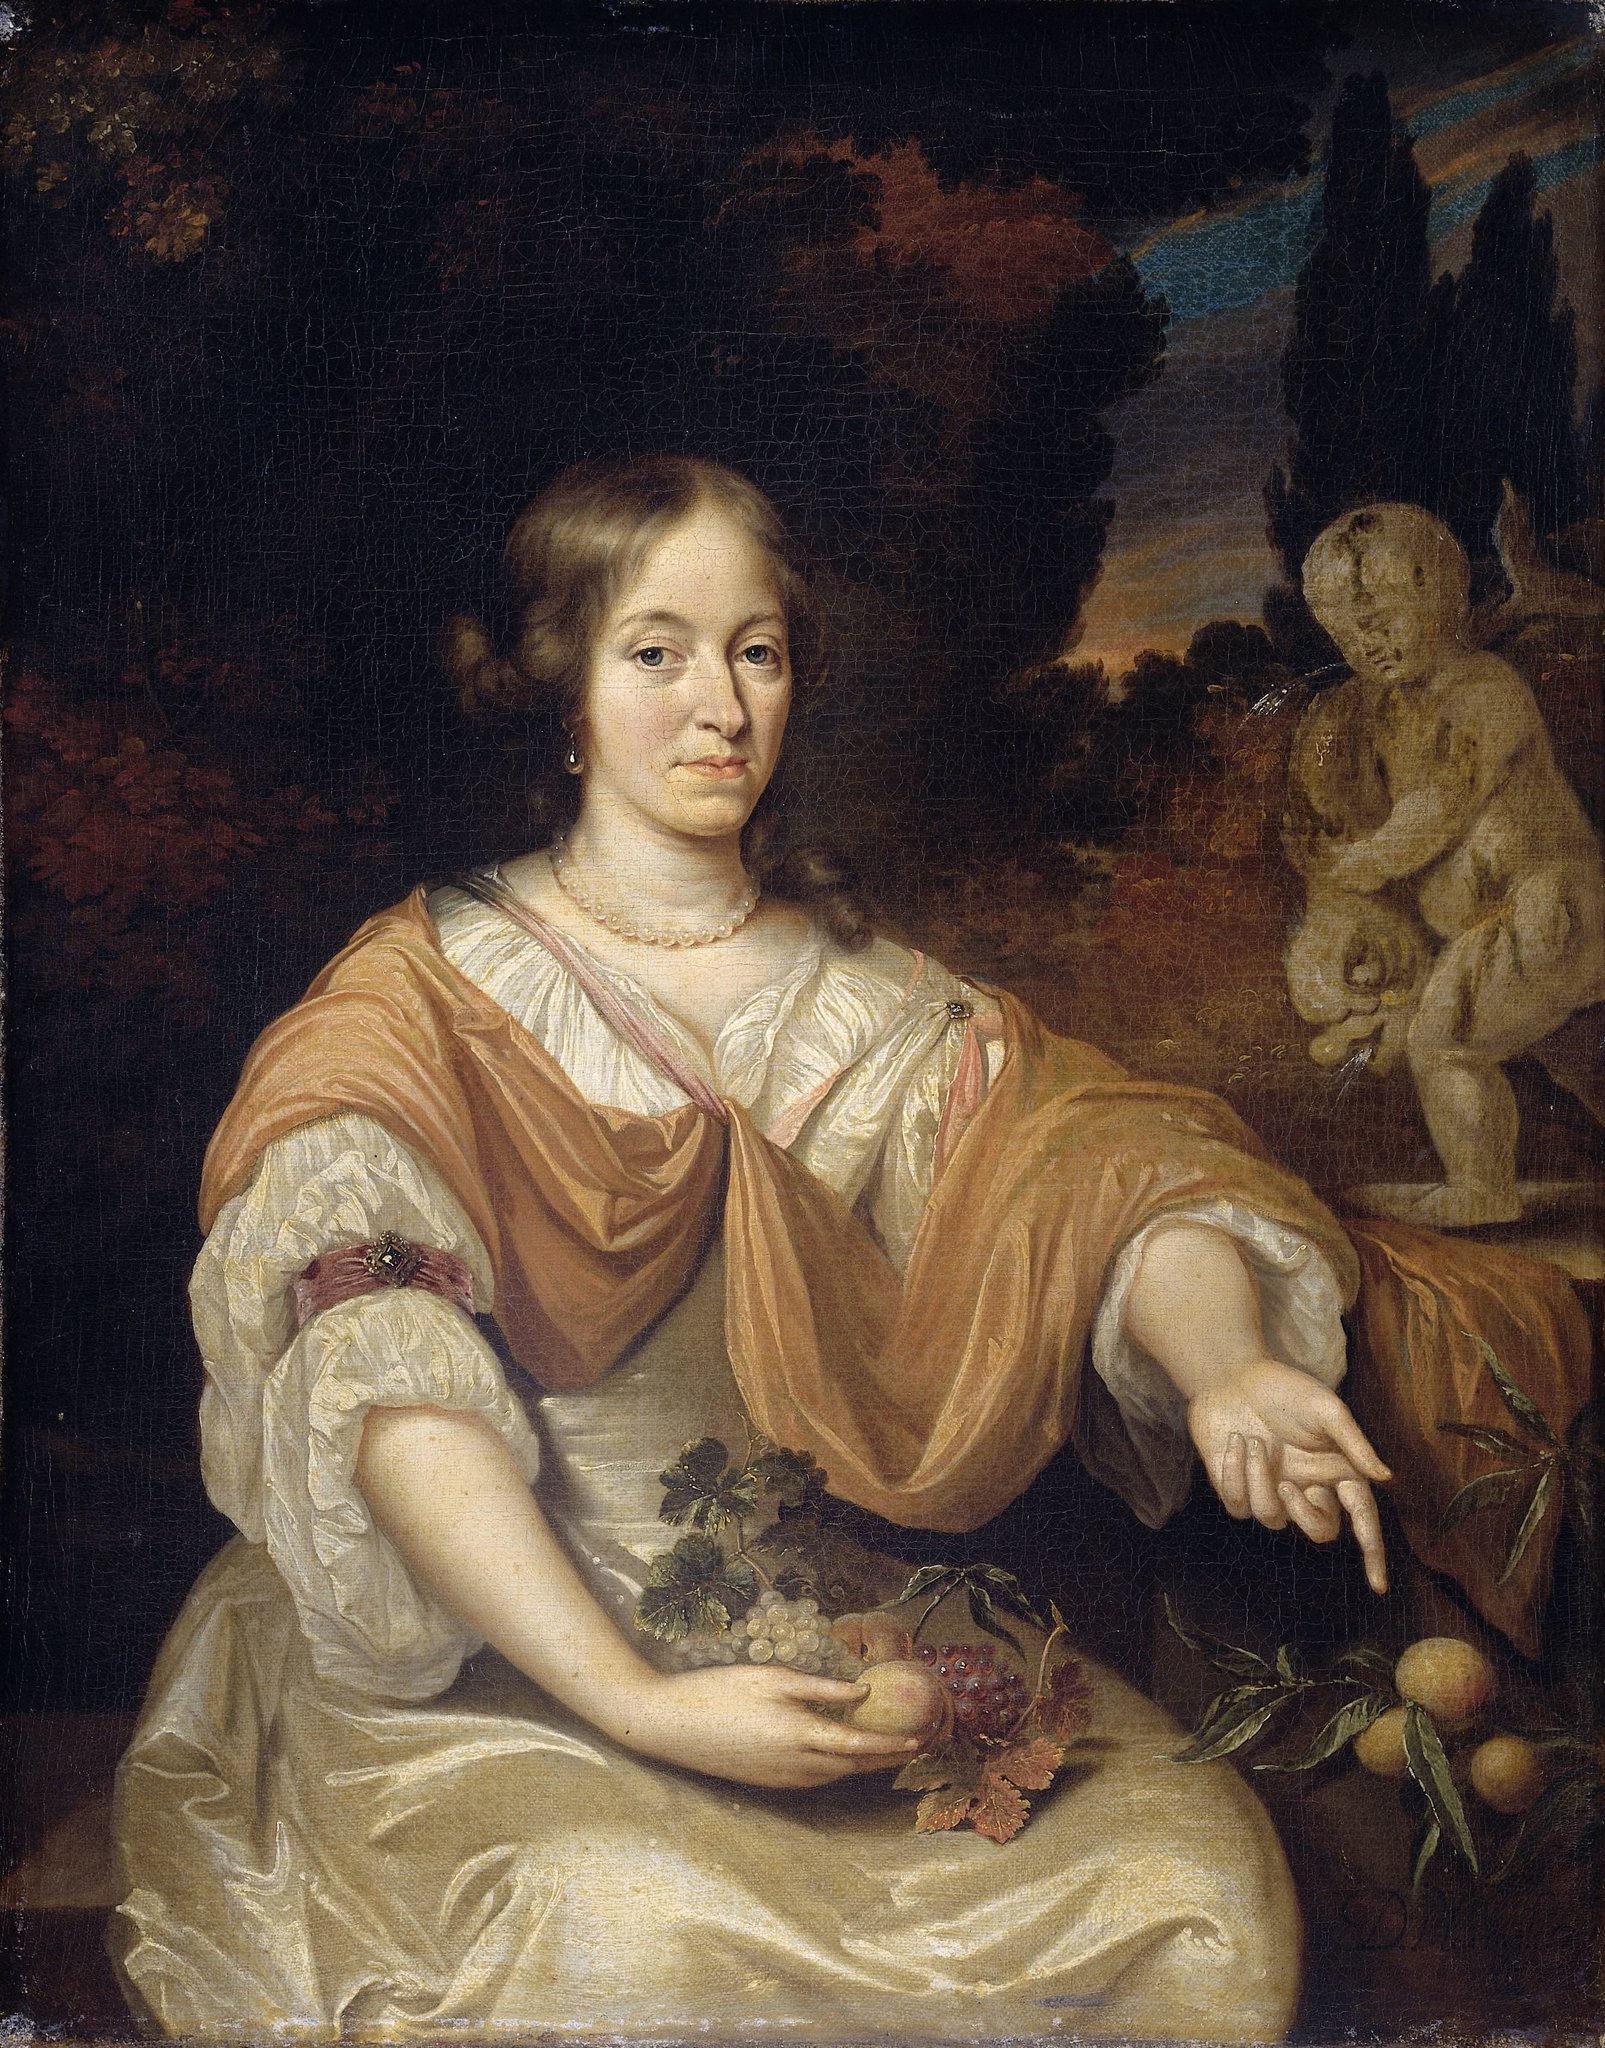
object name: painting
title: Sara Pottey (1651-1705), Wife of Johan van Bochoven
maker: daniël haringh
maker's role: painter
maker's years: 1636-1713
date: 1670-1690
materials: canvas, oil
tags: historical persons - bb - woman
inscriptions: signature: ‘D. Haringh F’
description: Portret van Sara Pottey, echtgenote van Johan van Bochoven. Kniestuk, zittend met een wijnrank met trossen druiven en ander fruit op haar schoot, rechts een standbeeld of fontein van een putto met een dolfijn. Ze wijst met haar linkerhand naar een tak met sinaasappels. Pendant van SK-A-1654.